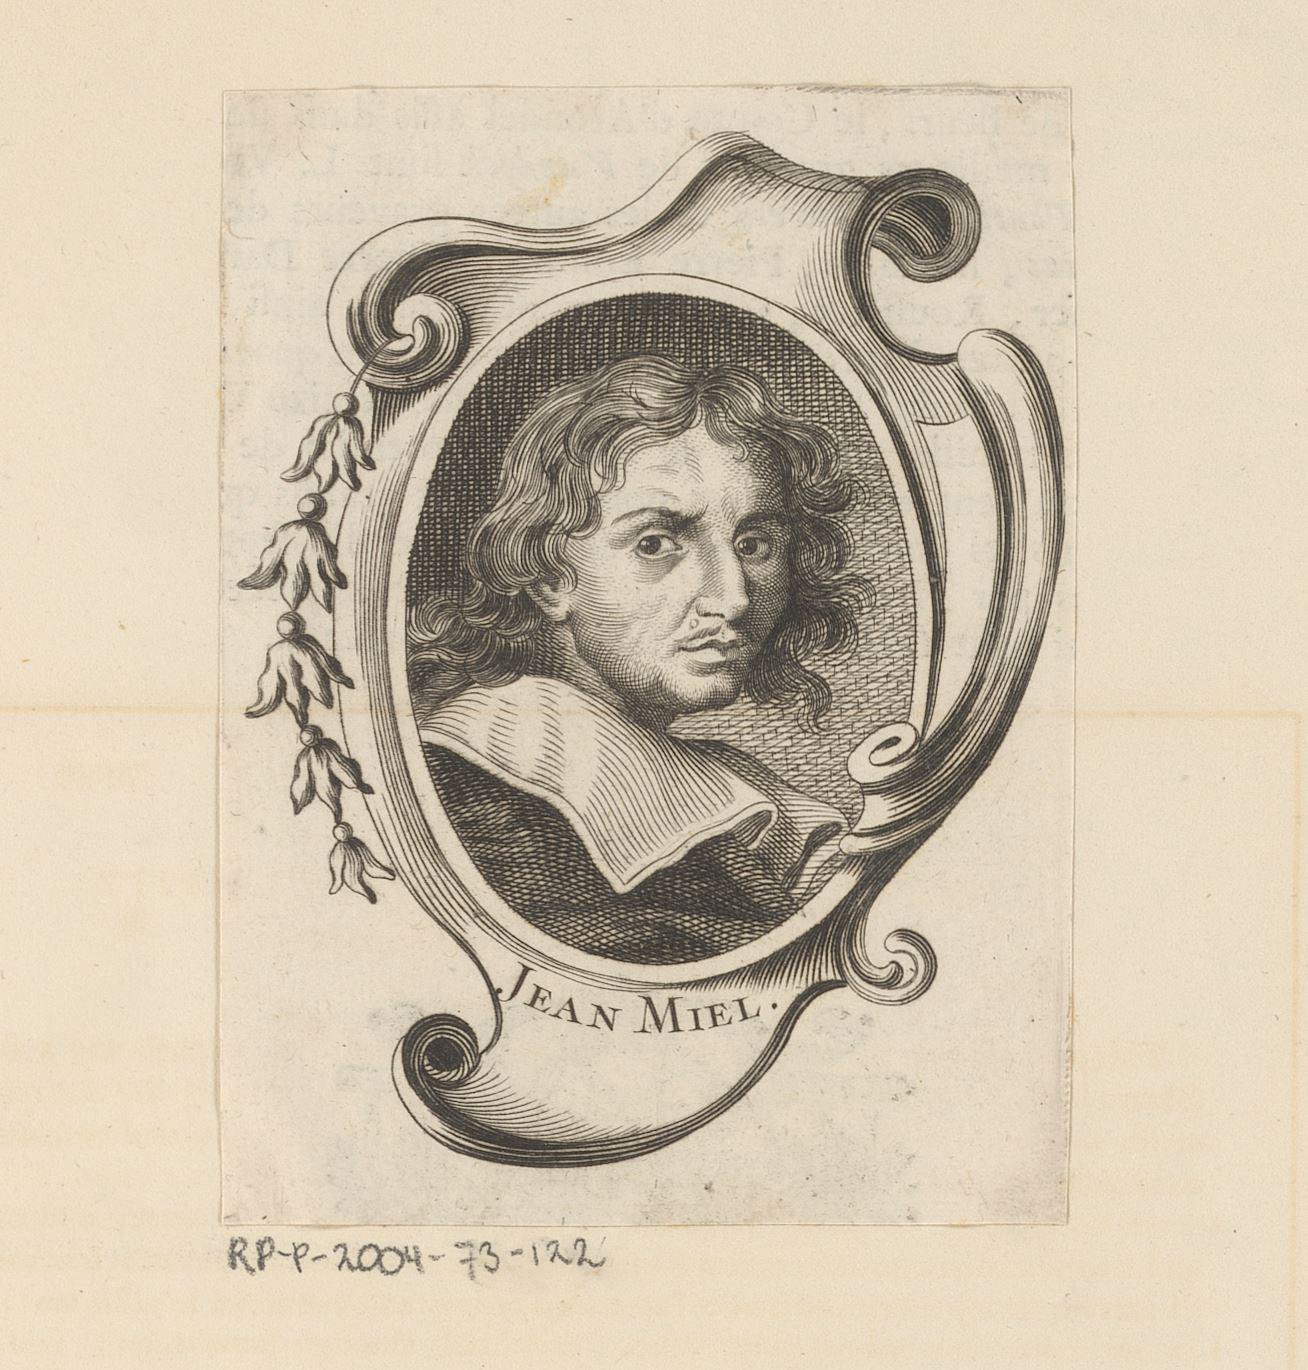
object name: album leaf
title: Jan Miel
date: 1745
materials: paper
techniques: engraving, letterpress printing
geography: paris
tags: painter, print maker, jan miel, historical persons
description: Prent uit: Dézallier d'Argenville, Antoine Joseph. Abrégé de la vie des plus fameux peintres. 4 dln. Parijs: De Bure l'aîné, 1745, dl. 2, p. 176. De samensteller heeft deze prent in het album geplakt als illustratie bij: Pilkington, Matthew en Johann Heinrich Füssli. A dictionary of painters, from the revival of the art to the present period. 4 dln. Londen: John Crowder, 1805, dl. 2, p. 355.